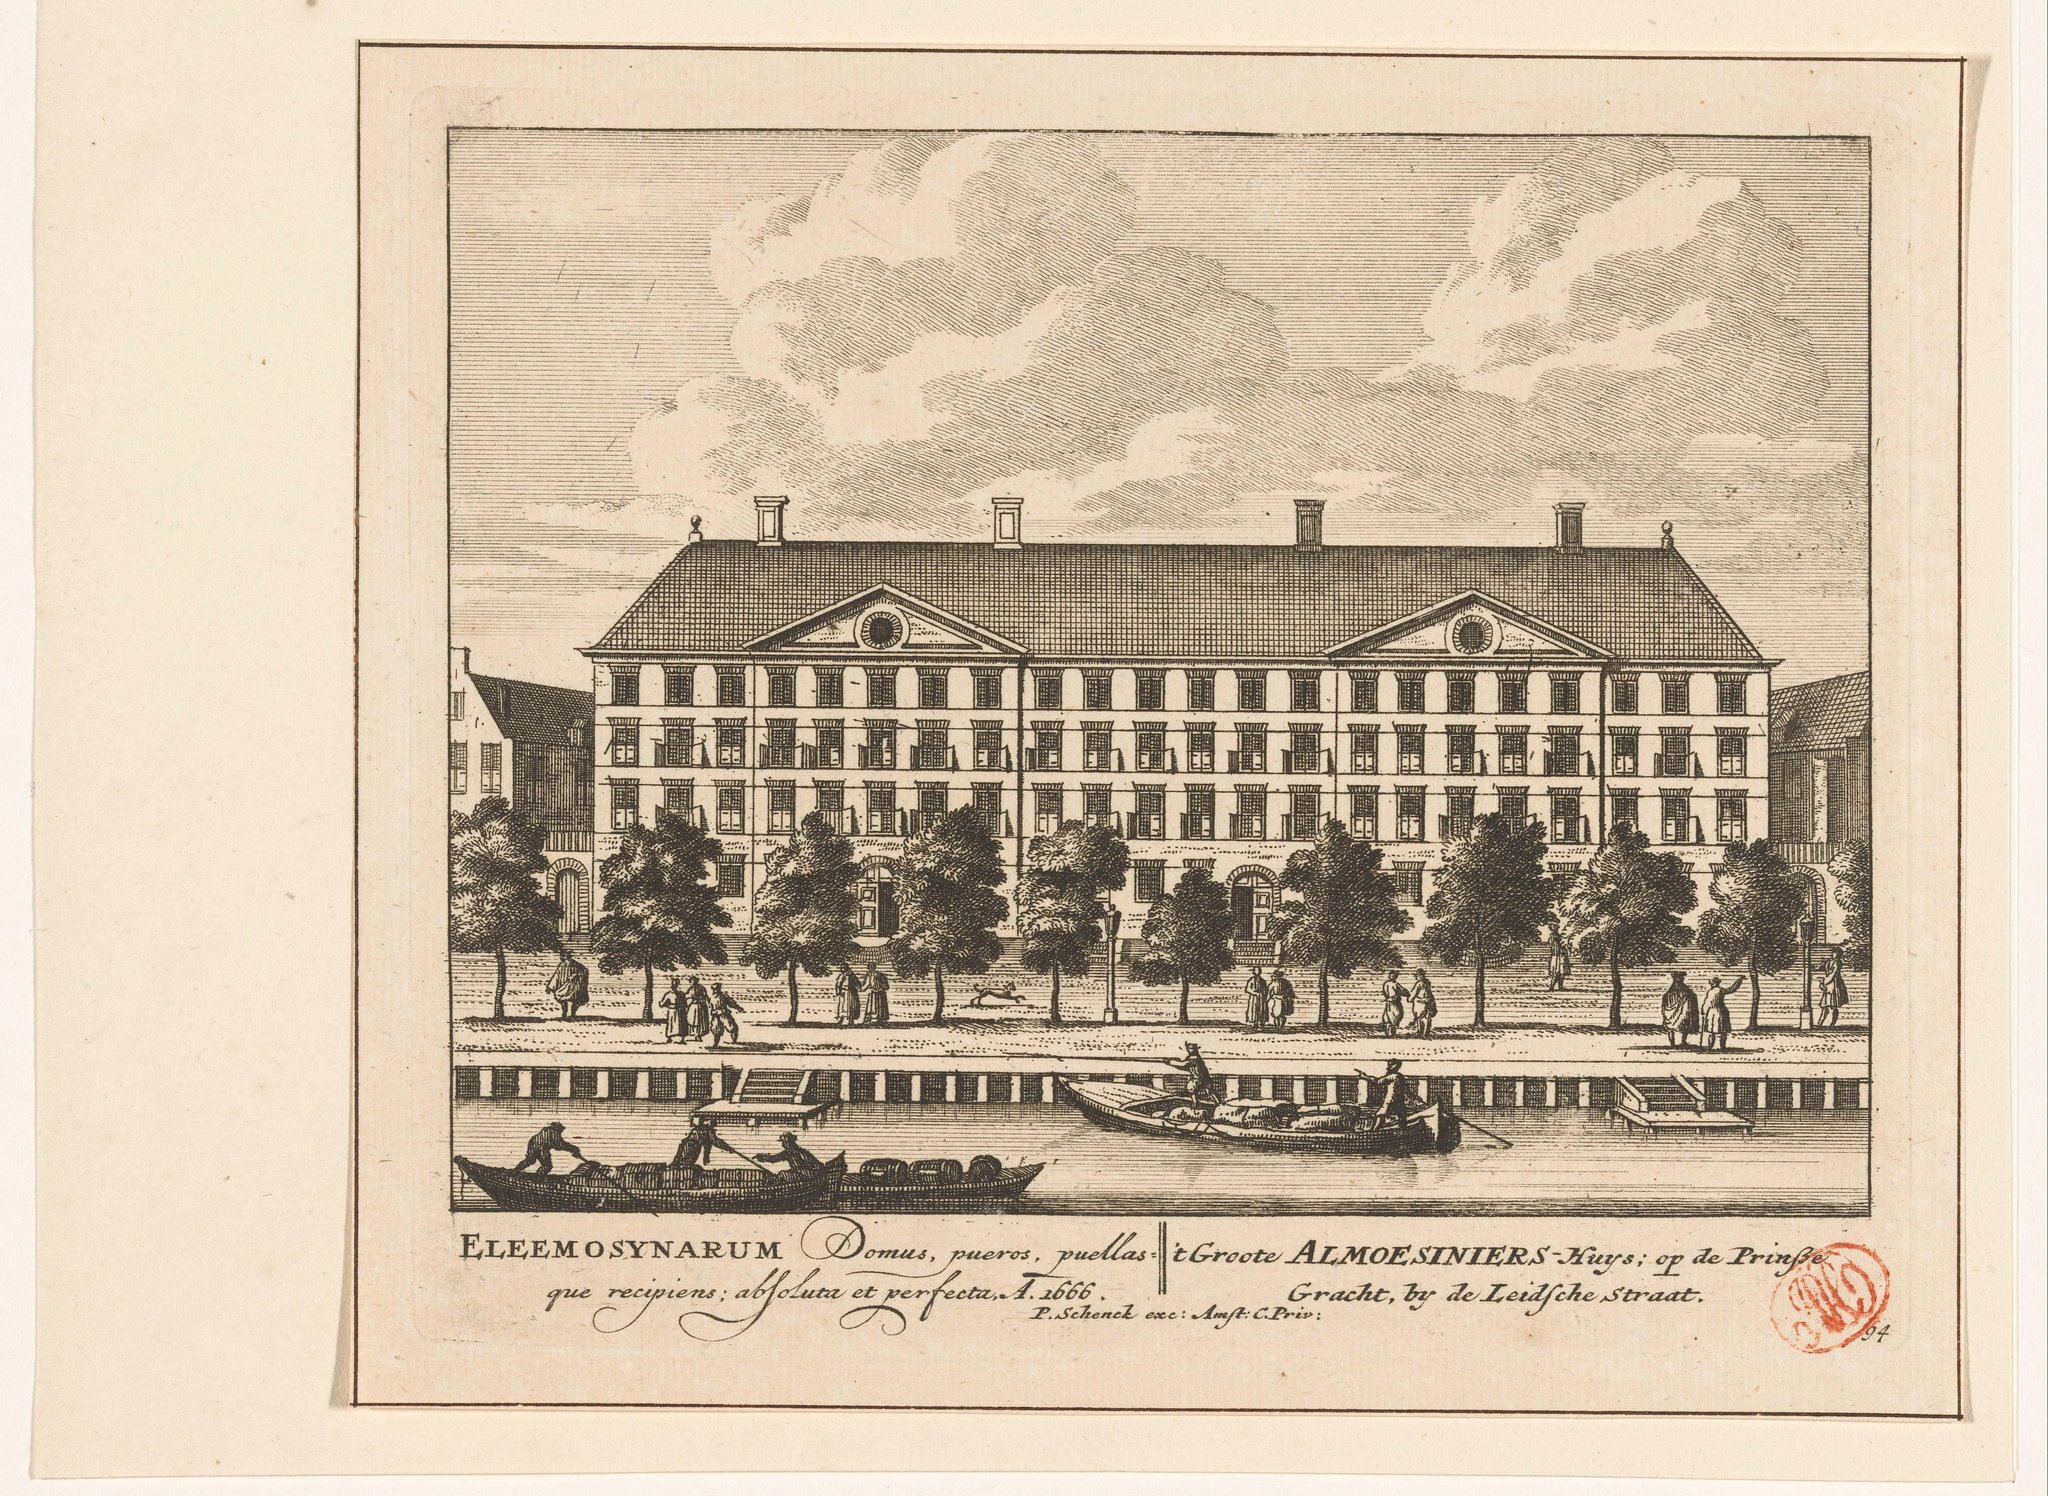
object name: print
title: 100 Afbeeldinge der voornaamste gebouwen van Amsterdam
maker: Anonymous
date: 1710-1711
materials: paper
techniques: engraving, etching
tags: public welfare, orphanage, canals, waters (in city) (+ city(-scape) with figures, staffage), street (+ city(-scape) with figures, staffage)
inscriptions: collector's mark: Lugt 195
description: Huidige staat van prent ook gebruikt in: 100 Afbeeldinge der voornaamste gebouwen van Amsterdam. Amsterdam, Pieter Schenk (I), s.a. [1710-1711]. En in: 100 Afbeeldinge der voornaamste gebouwen van Amsterdam. Amsterdam, Barent Greve, s.a. [1757-1766].* *In de tweede uitgave, uitgegeven door Barent Greve, is alleen de titelprent aangepast. De overige prenten zijn onveranderd gebleven.